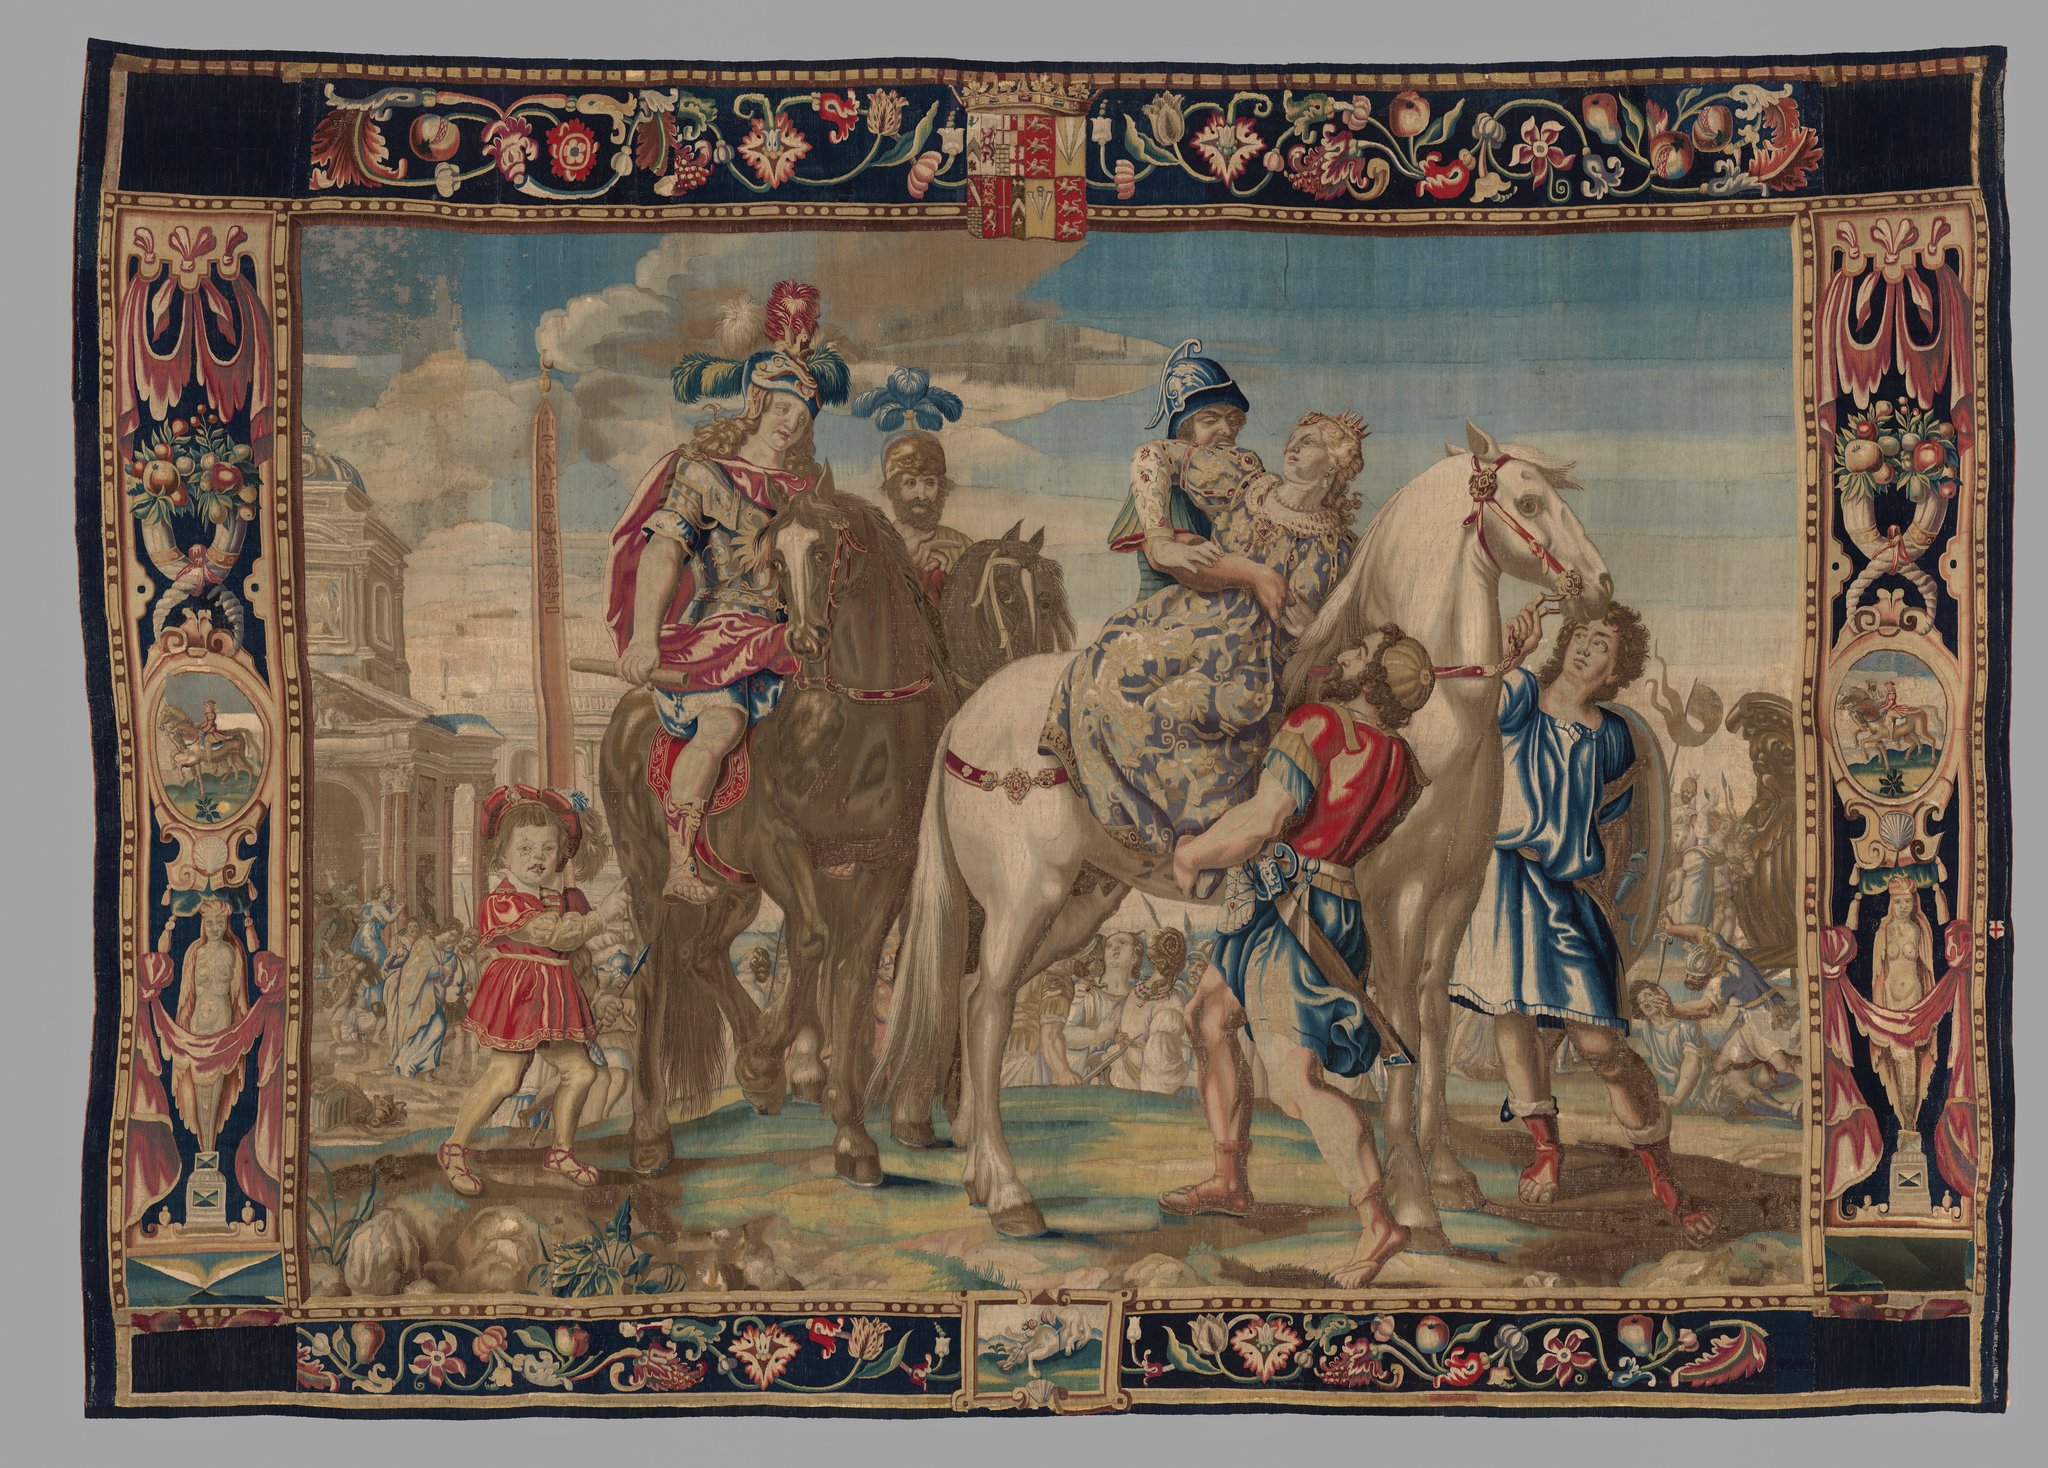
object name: tapestry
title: The Abduction of Cassandra by Ajax from a set of The Horses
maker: frans cleyn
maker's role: designer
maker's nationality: german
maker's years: 1582-1658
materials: silk, wool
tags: boys,men,women,horses,coat of arms,ajax